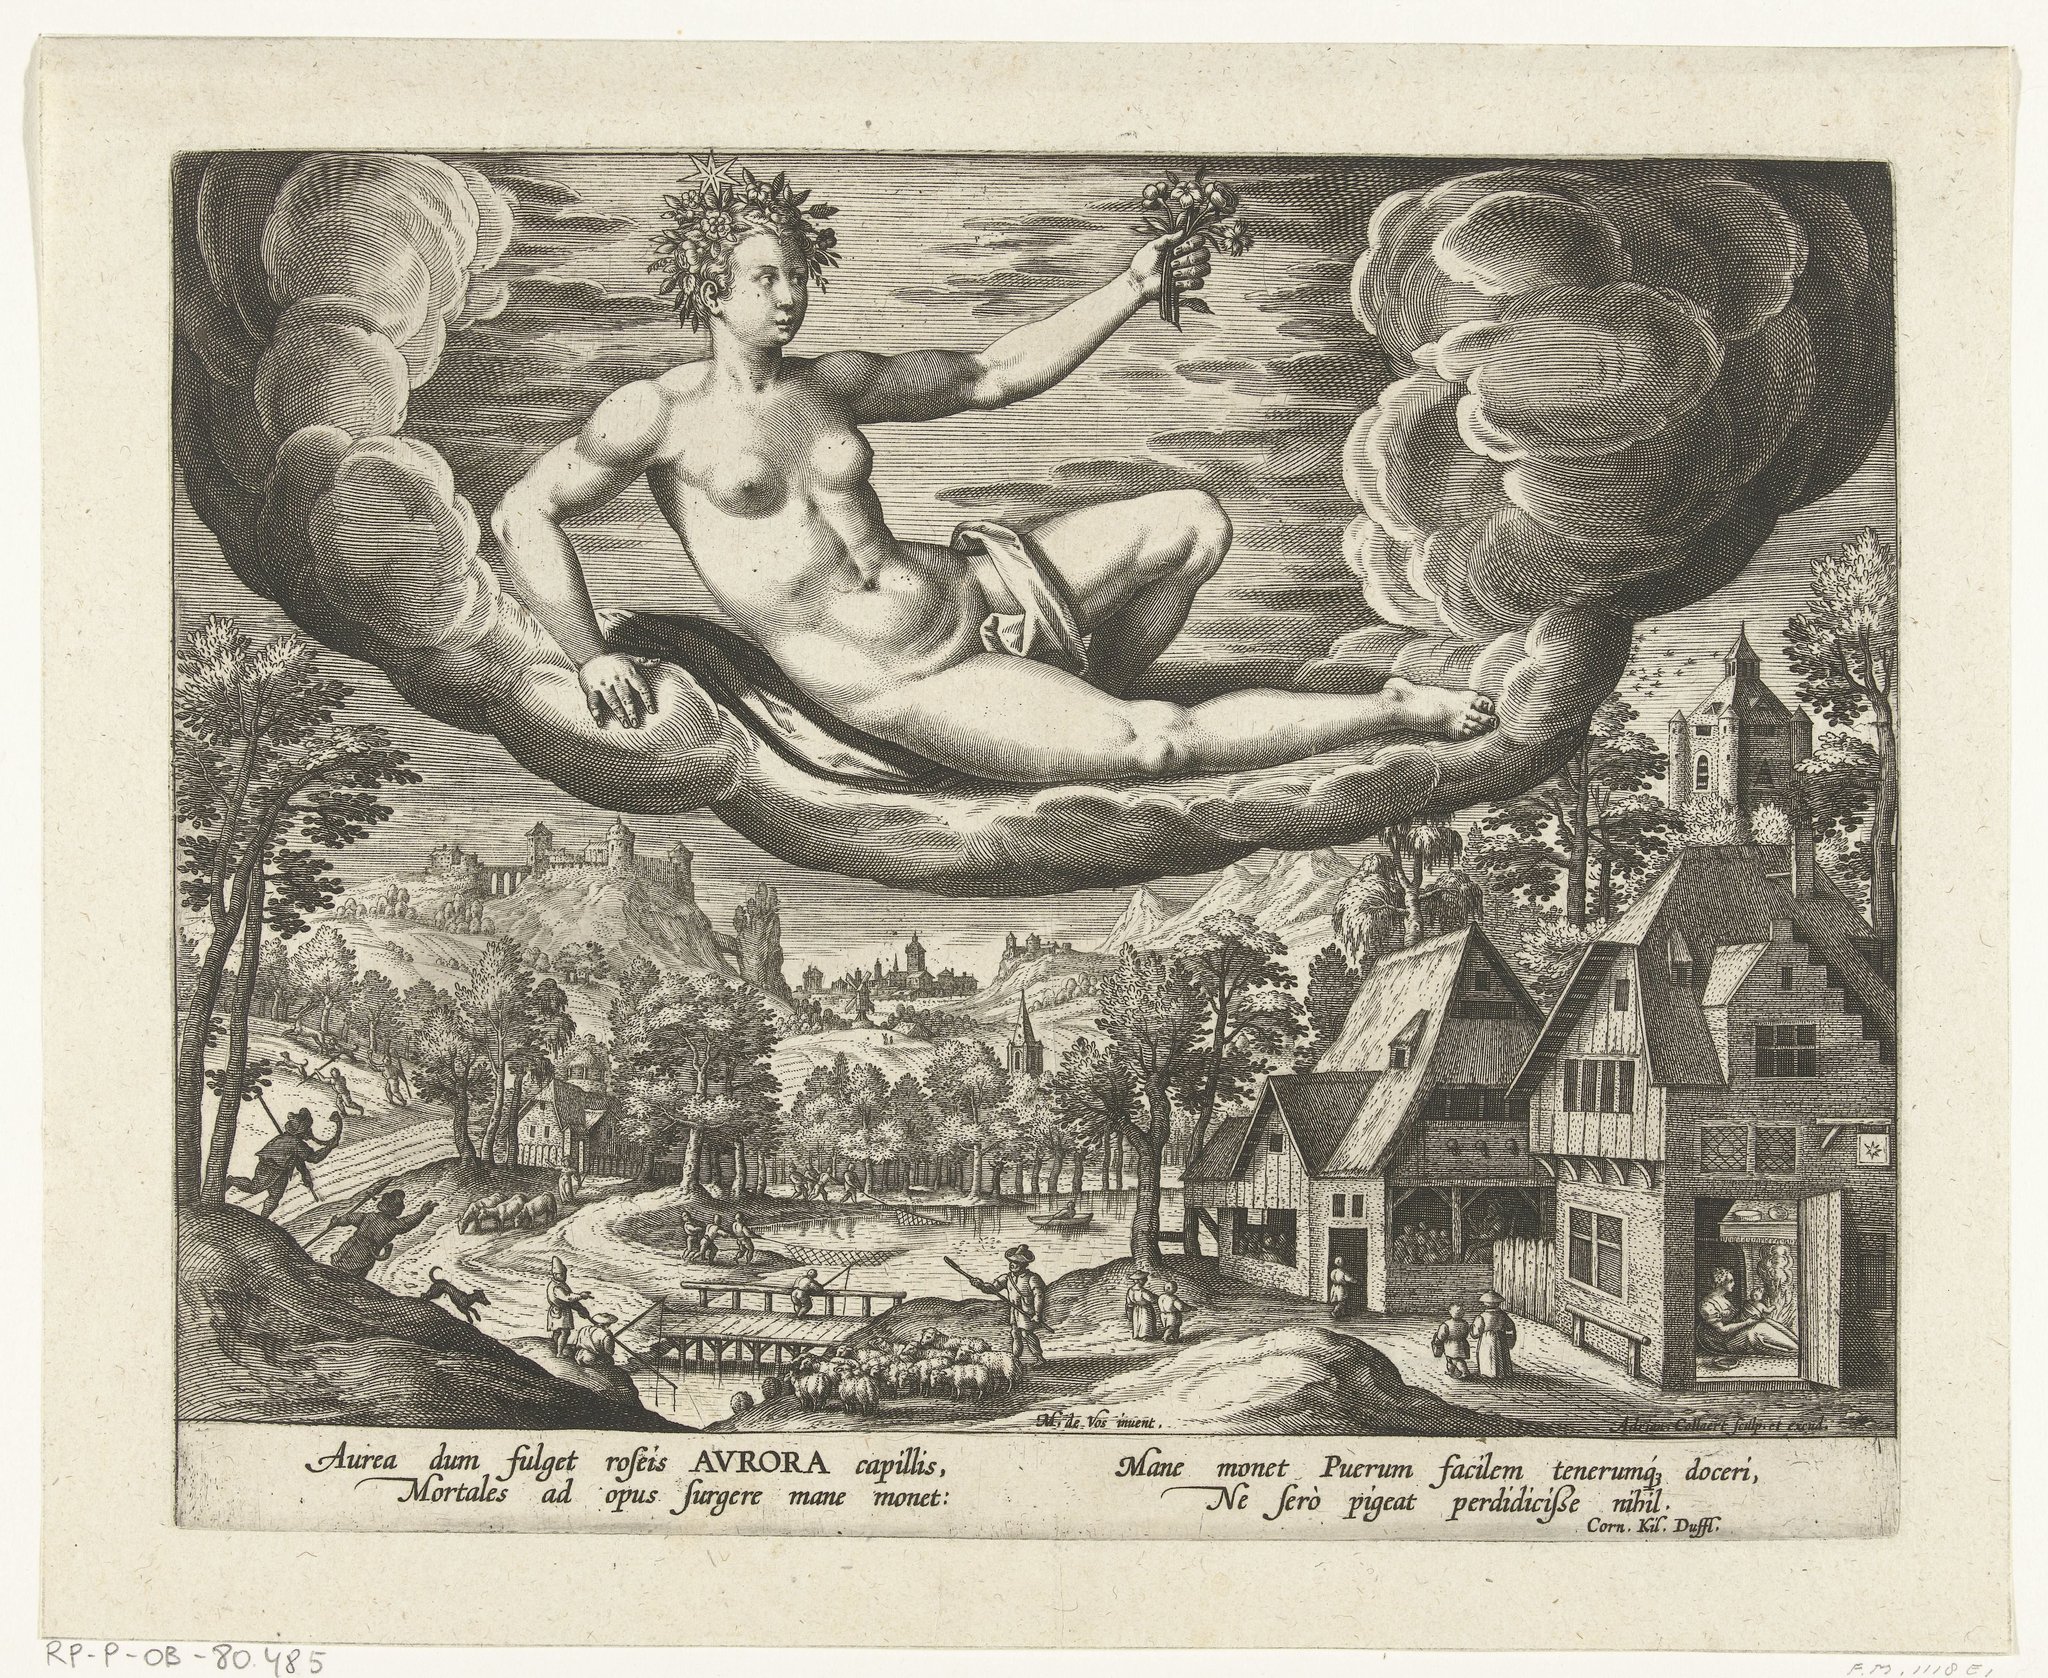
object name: print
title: De vier tijden van de dag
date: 1590-1597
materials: paper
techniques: engraving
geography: antwerp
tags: personification of the morning, 'aurora'; 'aurora' (ripa), childhood (alleg.), elementary school; class, form, low countries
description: Ochtend. Allegorie met in de wolken Aurora, de personificatie van de ochtend. Beneden op aarde activiteiten in relatie met de levensfase van de kindertijd: schoolgaande kinderen. Onderdeel van de serie van de vier tijden van de dag. Onder de voorstelling een opschrift van 4 regels in het Latijn.